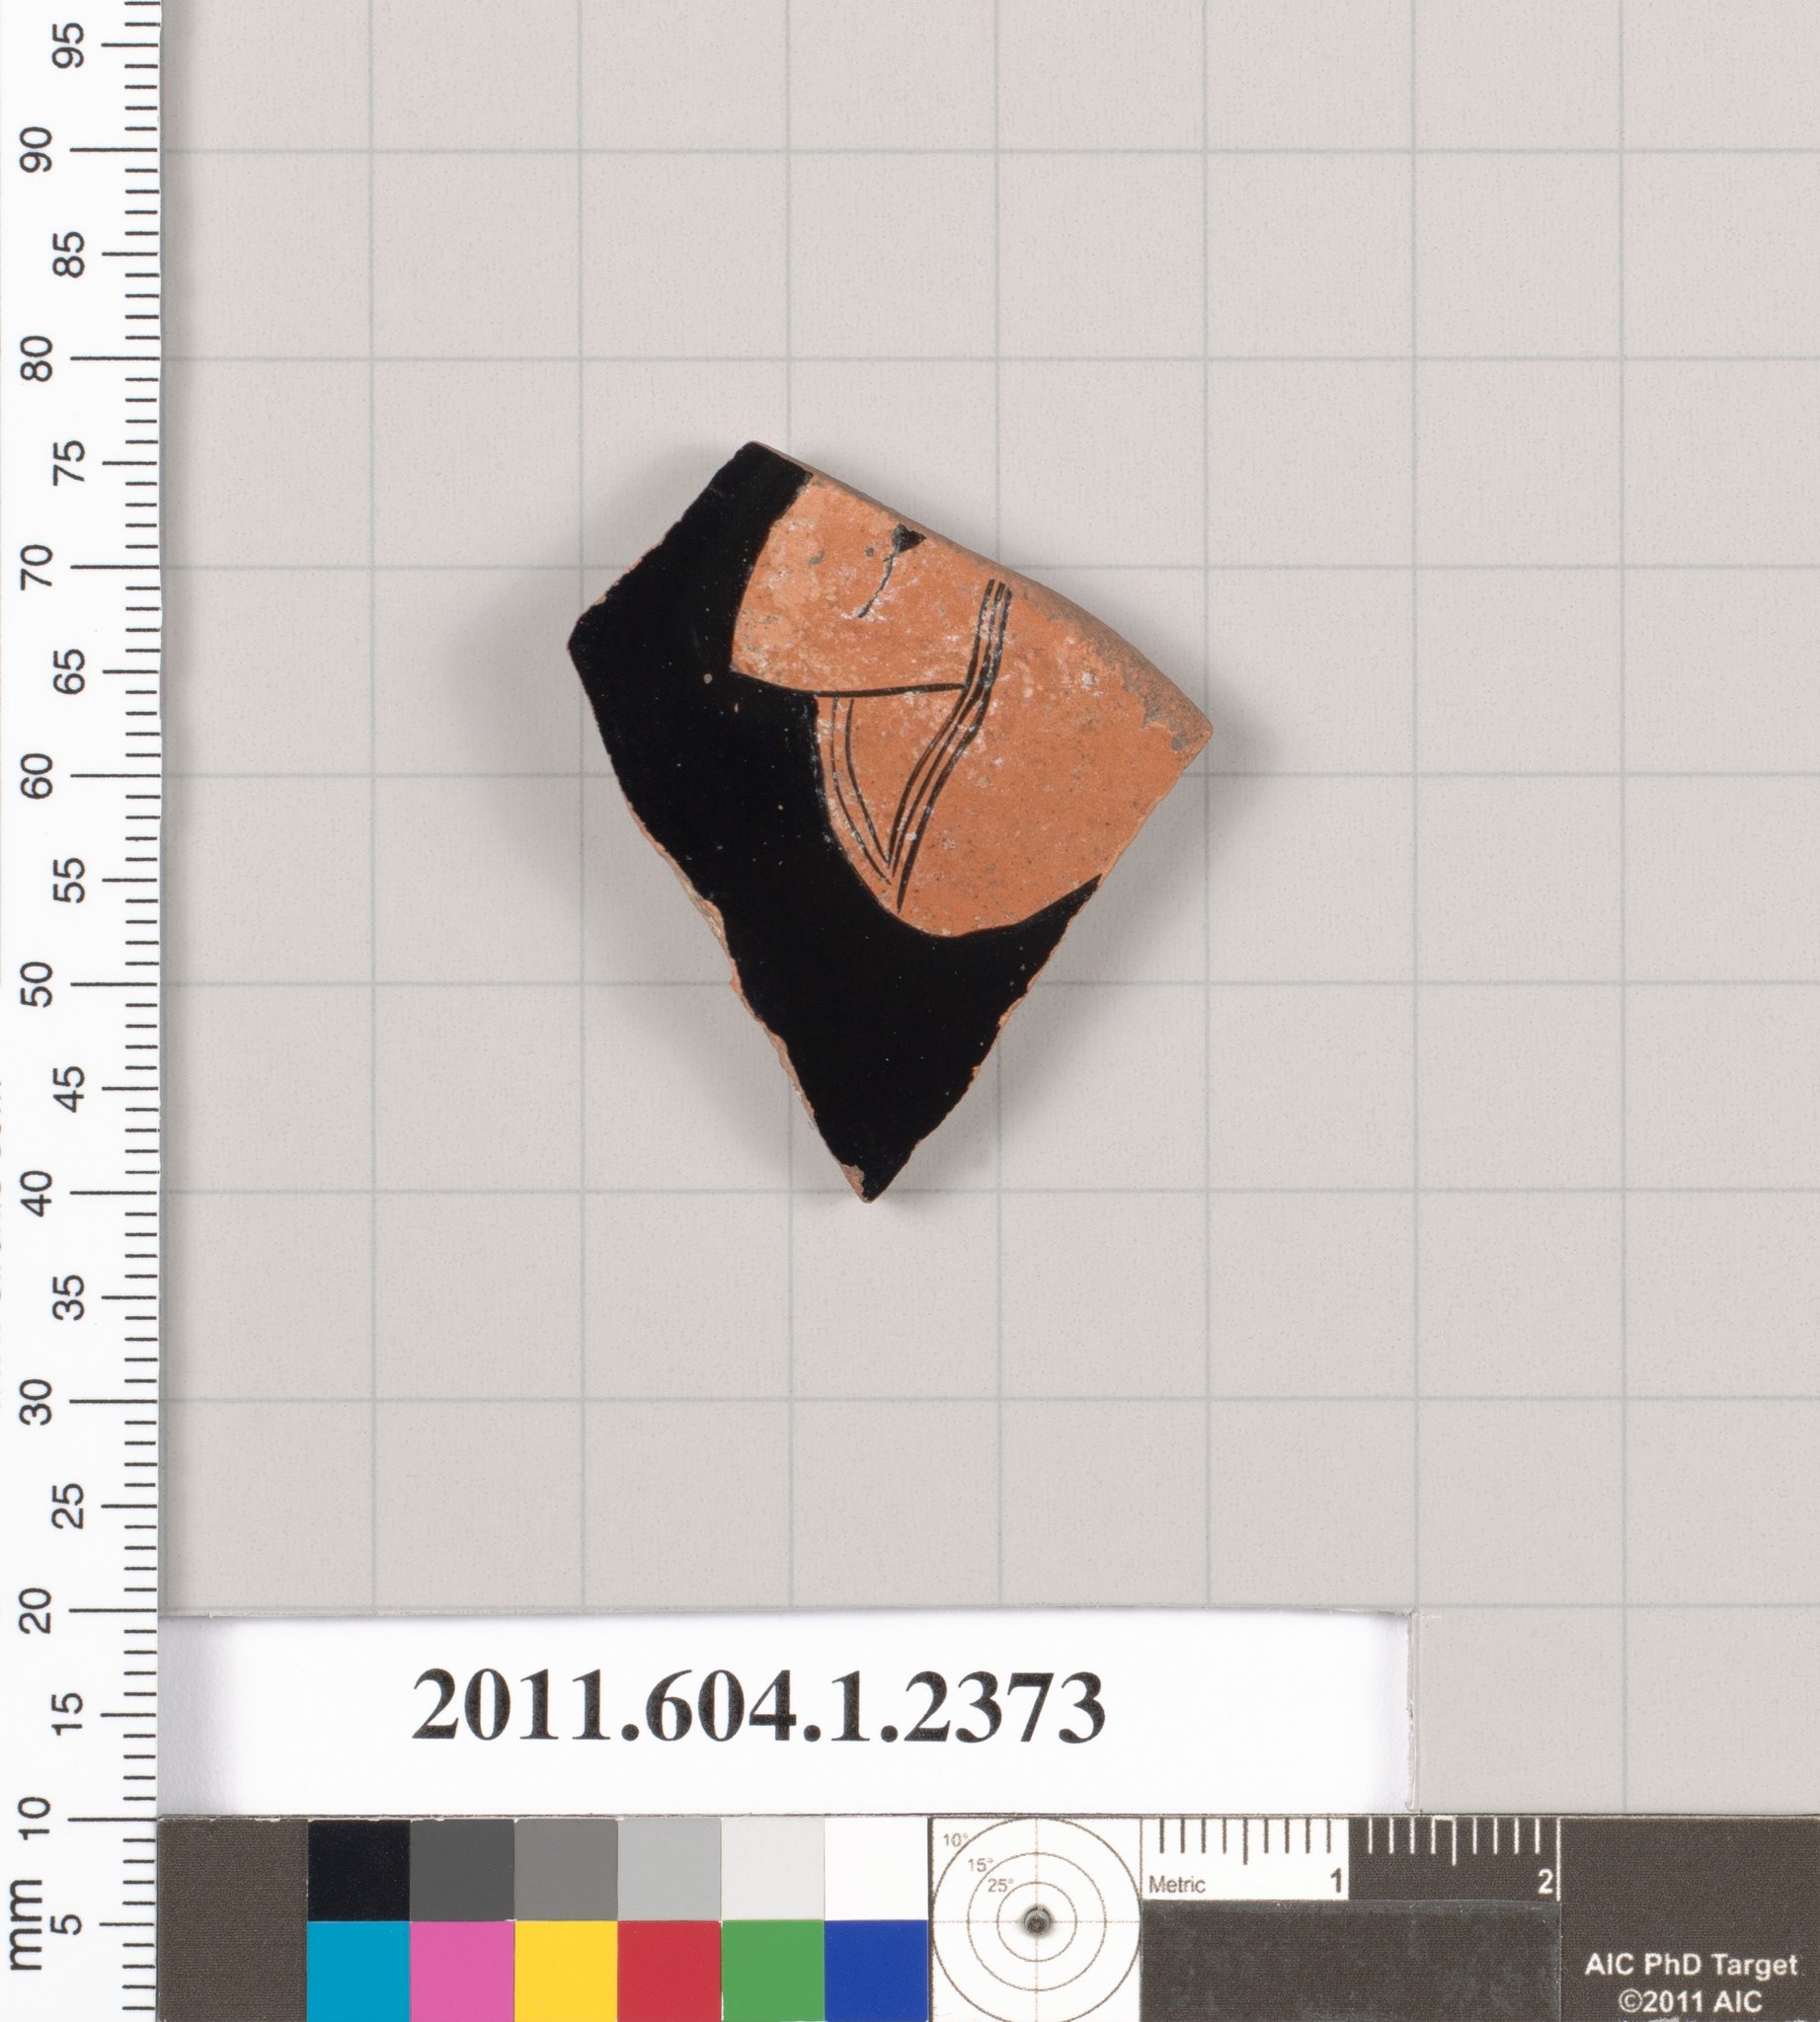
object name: kylix fragment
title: Terracotta fragment of a kylix (drinking cup)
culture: greek, attic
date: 500-490 BCE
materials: terracotta